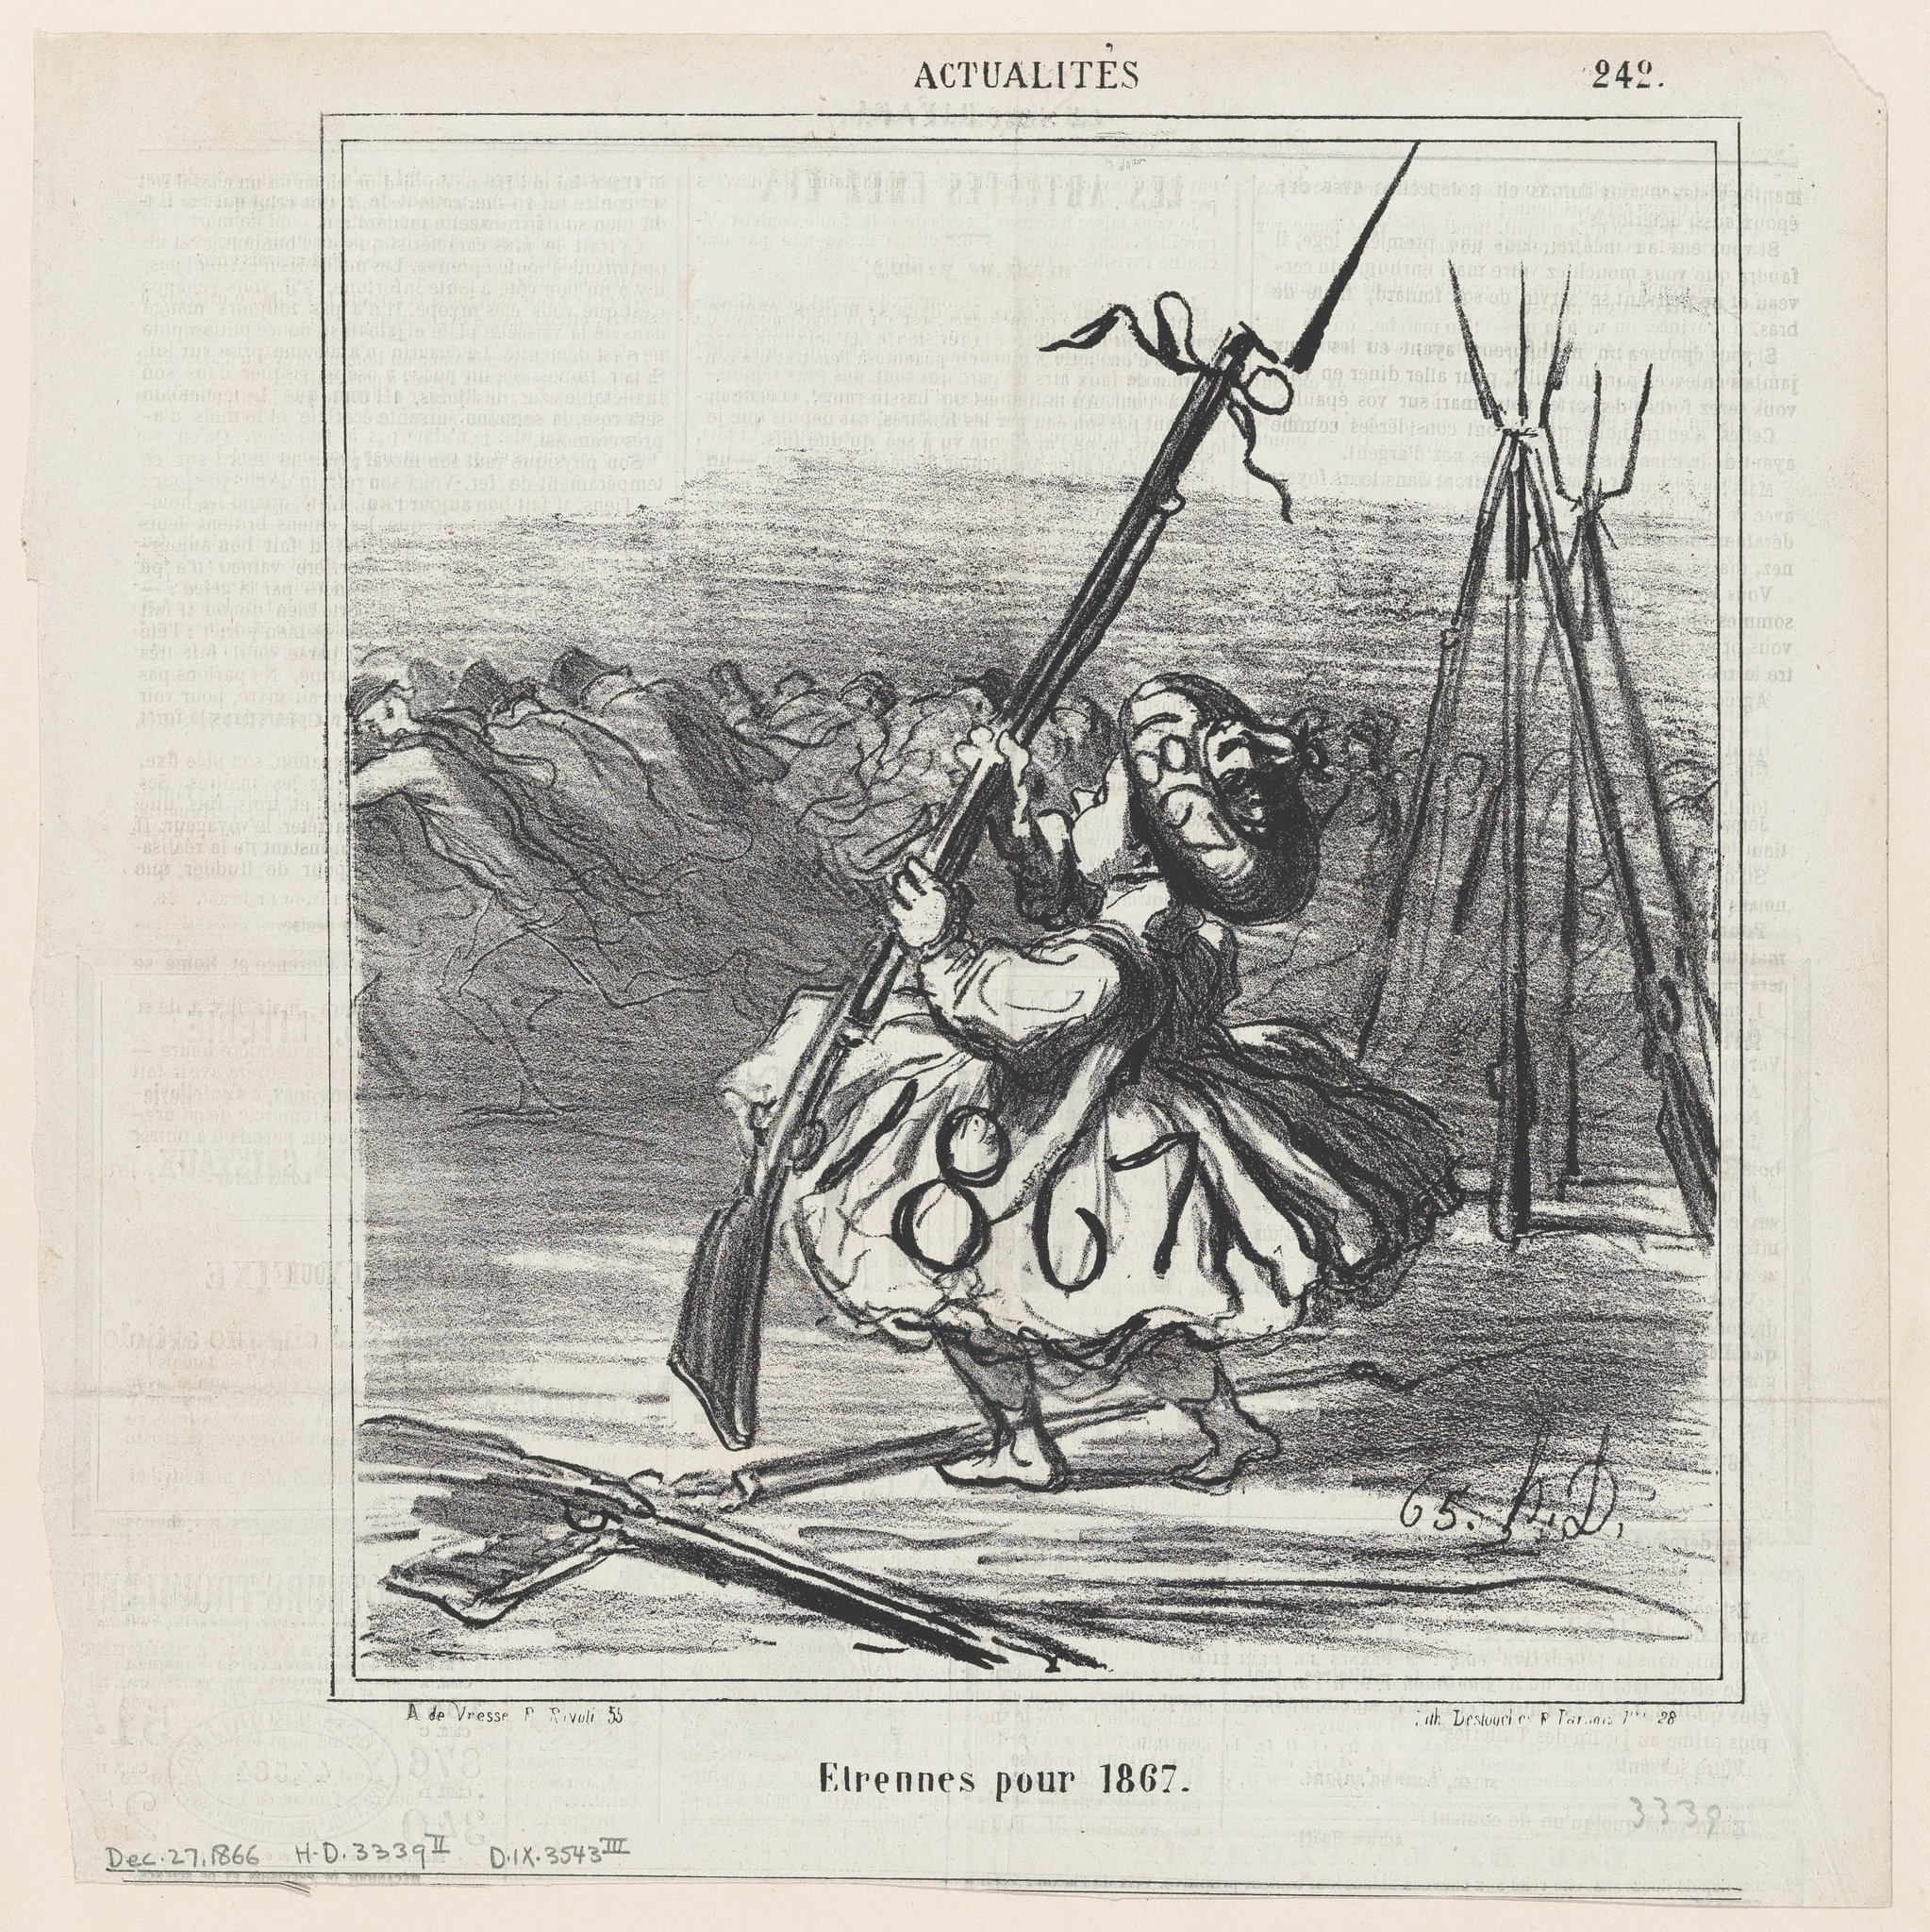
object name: print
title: New Year's gifts for 1867, from 'News of the day,' published in Le Charivari, December 27, 1866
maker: honoré daumier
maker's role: artist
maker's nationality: french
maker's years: 1808-1879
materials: paper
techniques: lithograph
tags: firearms,girls